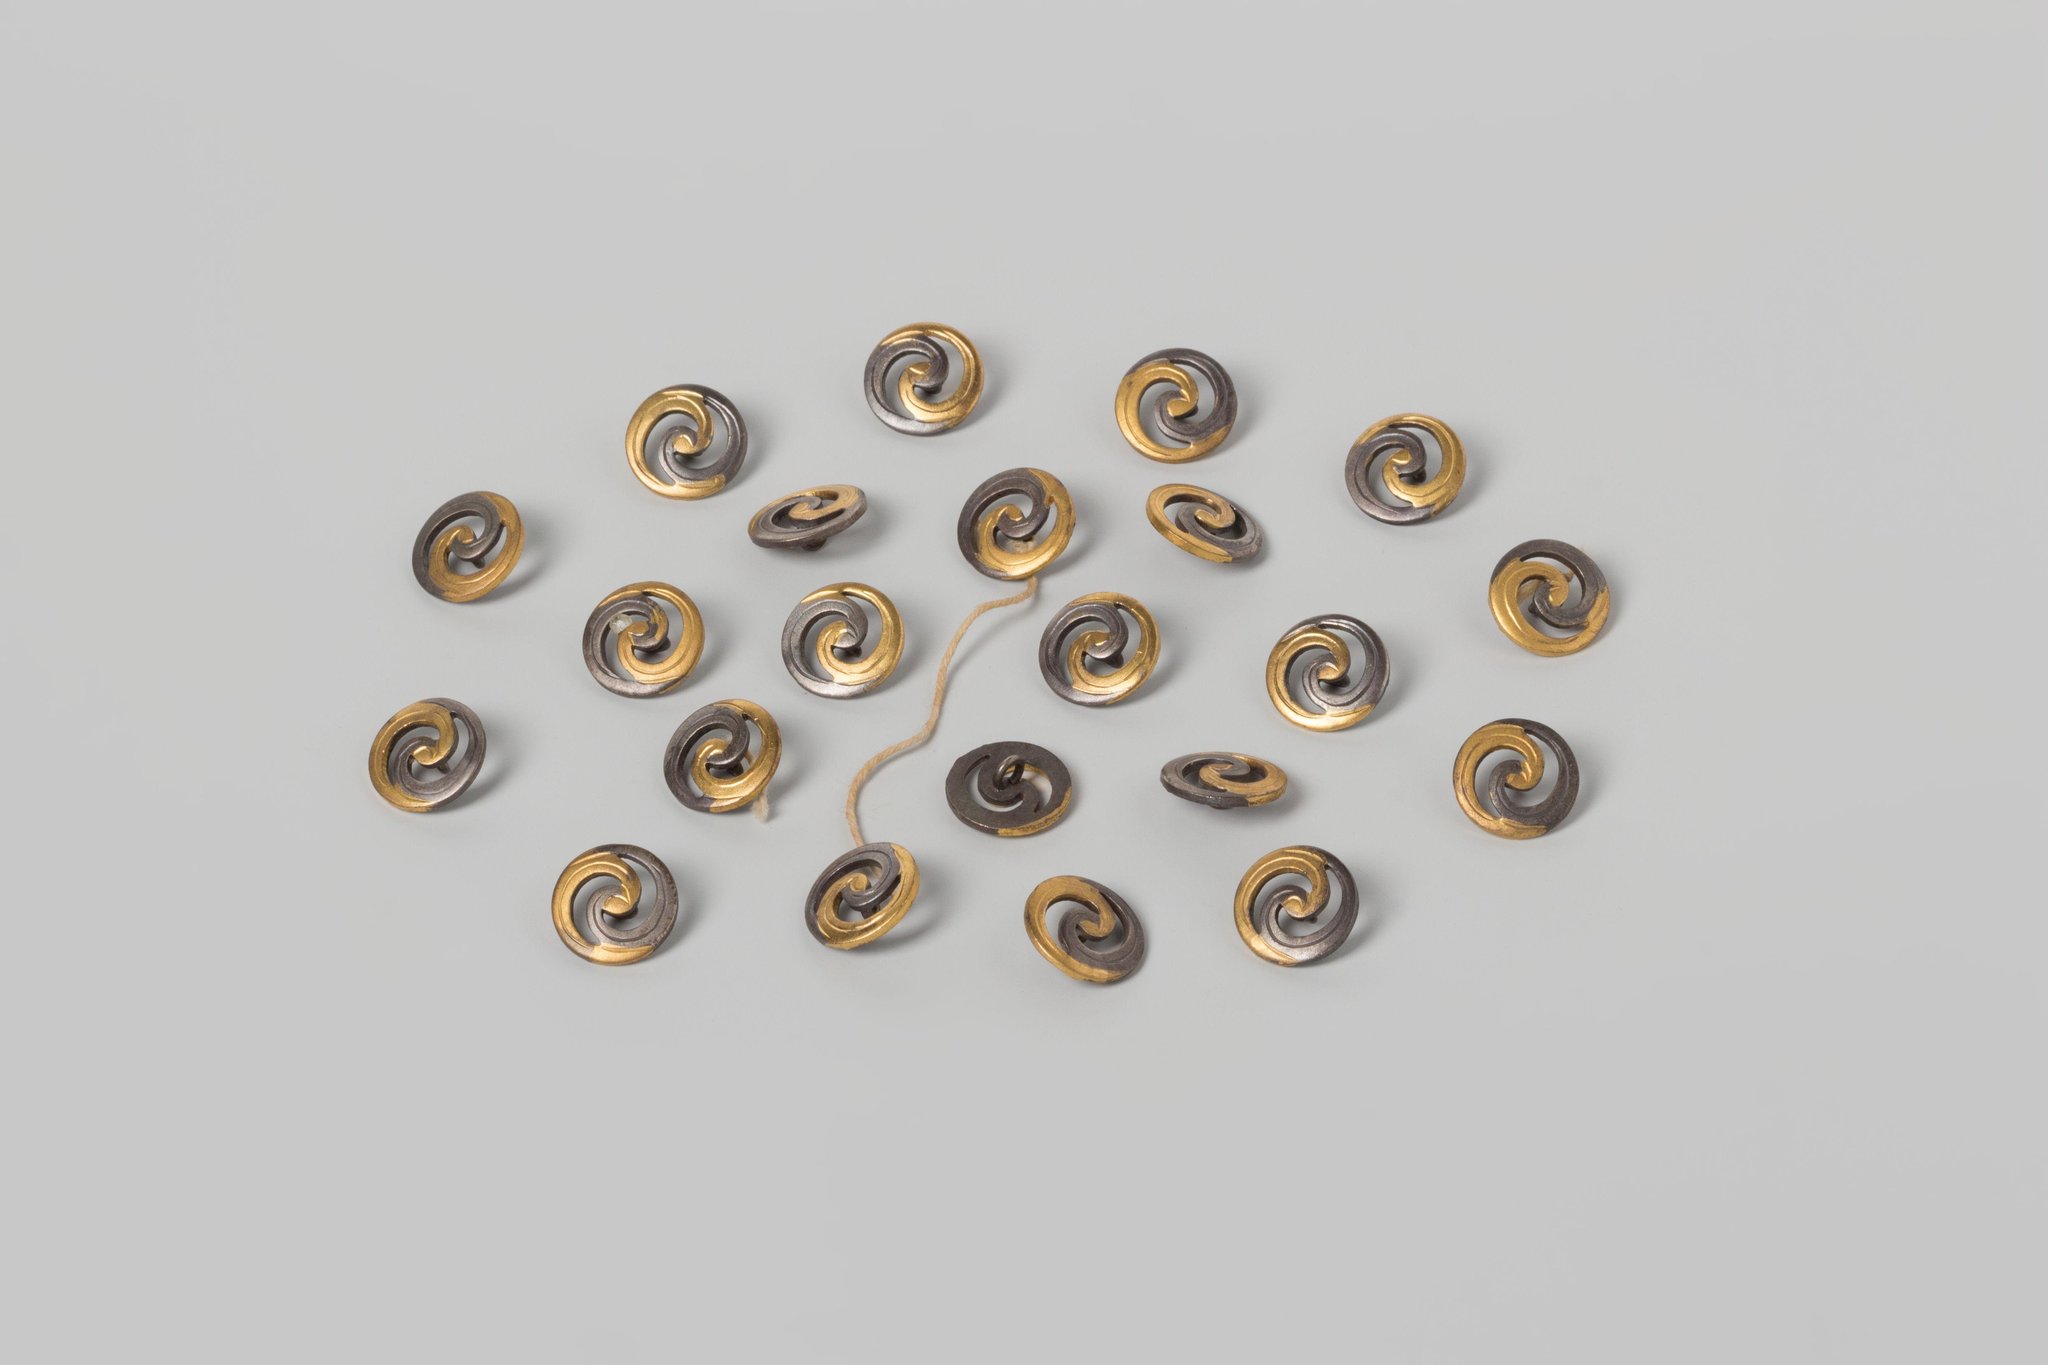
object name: clothing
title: Knoop, plat en rond, van gedeeltelijk met goudverf beschilderd metaal met krulmotief, gelijkend yin en yang, opengewerkt en gegraveerd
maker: Anonymous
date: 1880-1940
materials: paint, metal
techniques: embroidery, engraving, painting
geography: europe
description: Knoop, plat en rond, van gedeeltelijk met goudverf beschilderd metaal met krulmotief, gelijkend yin en yang, opengewerkt en gegraveerd.